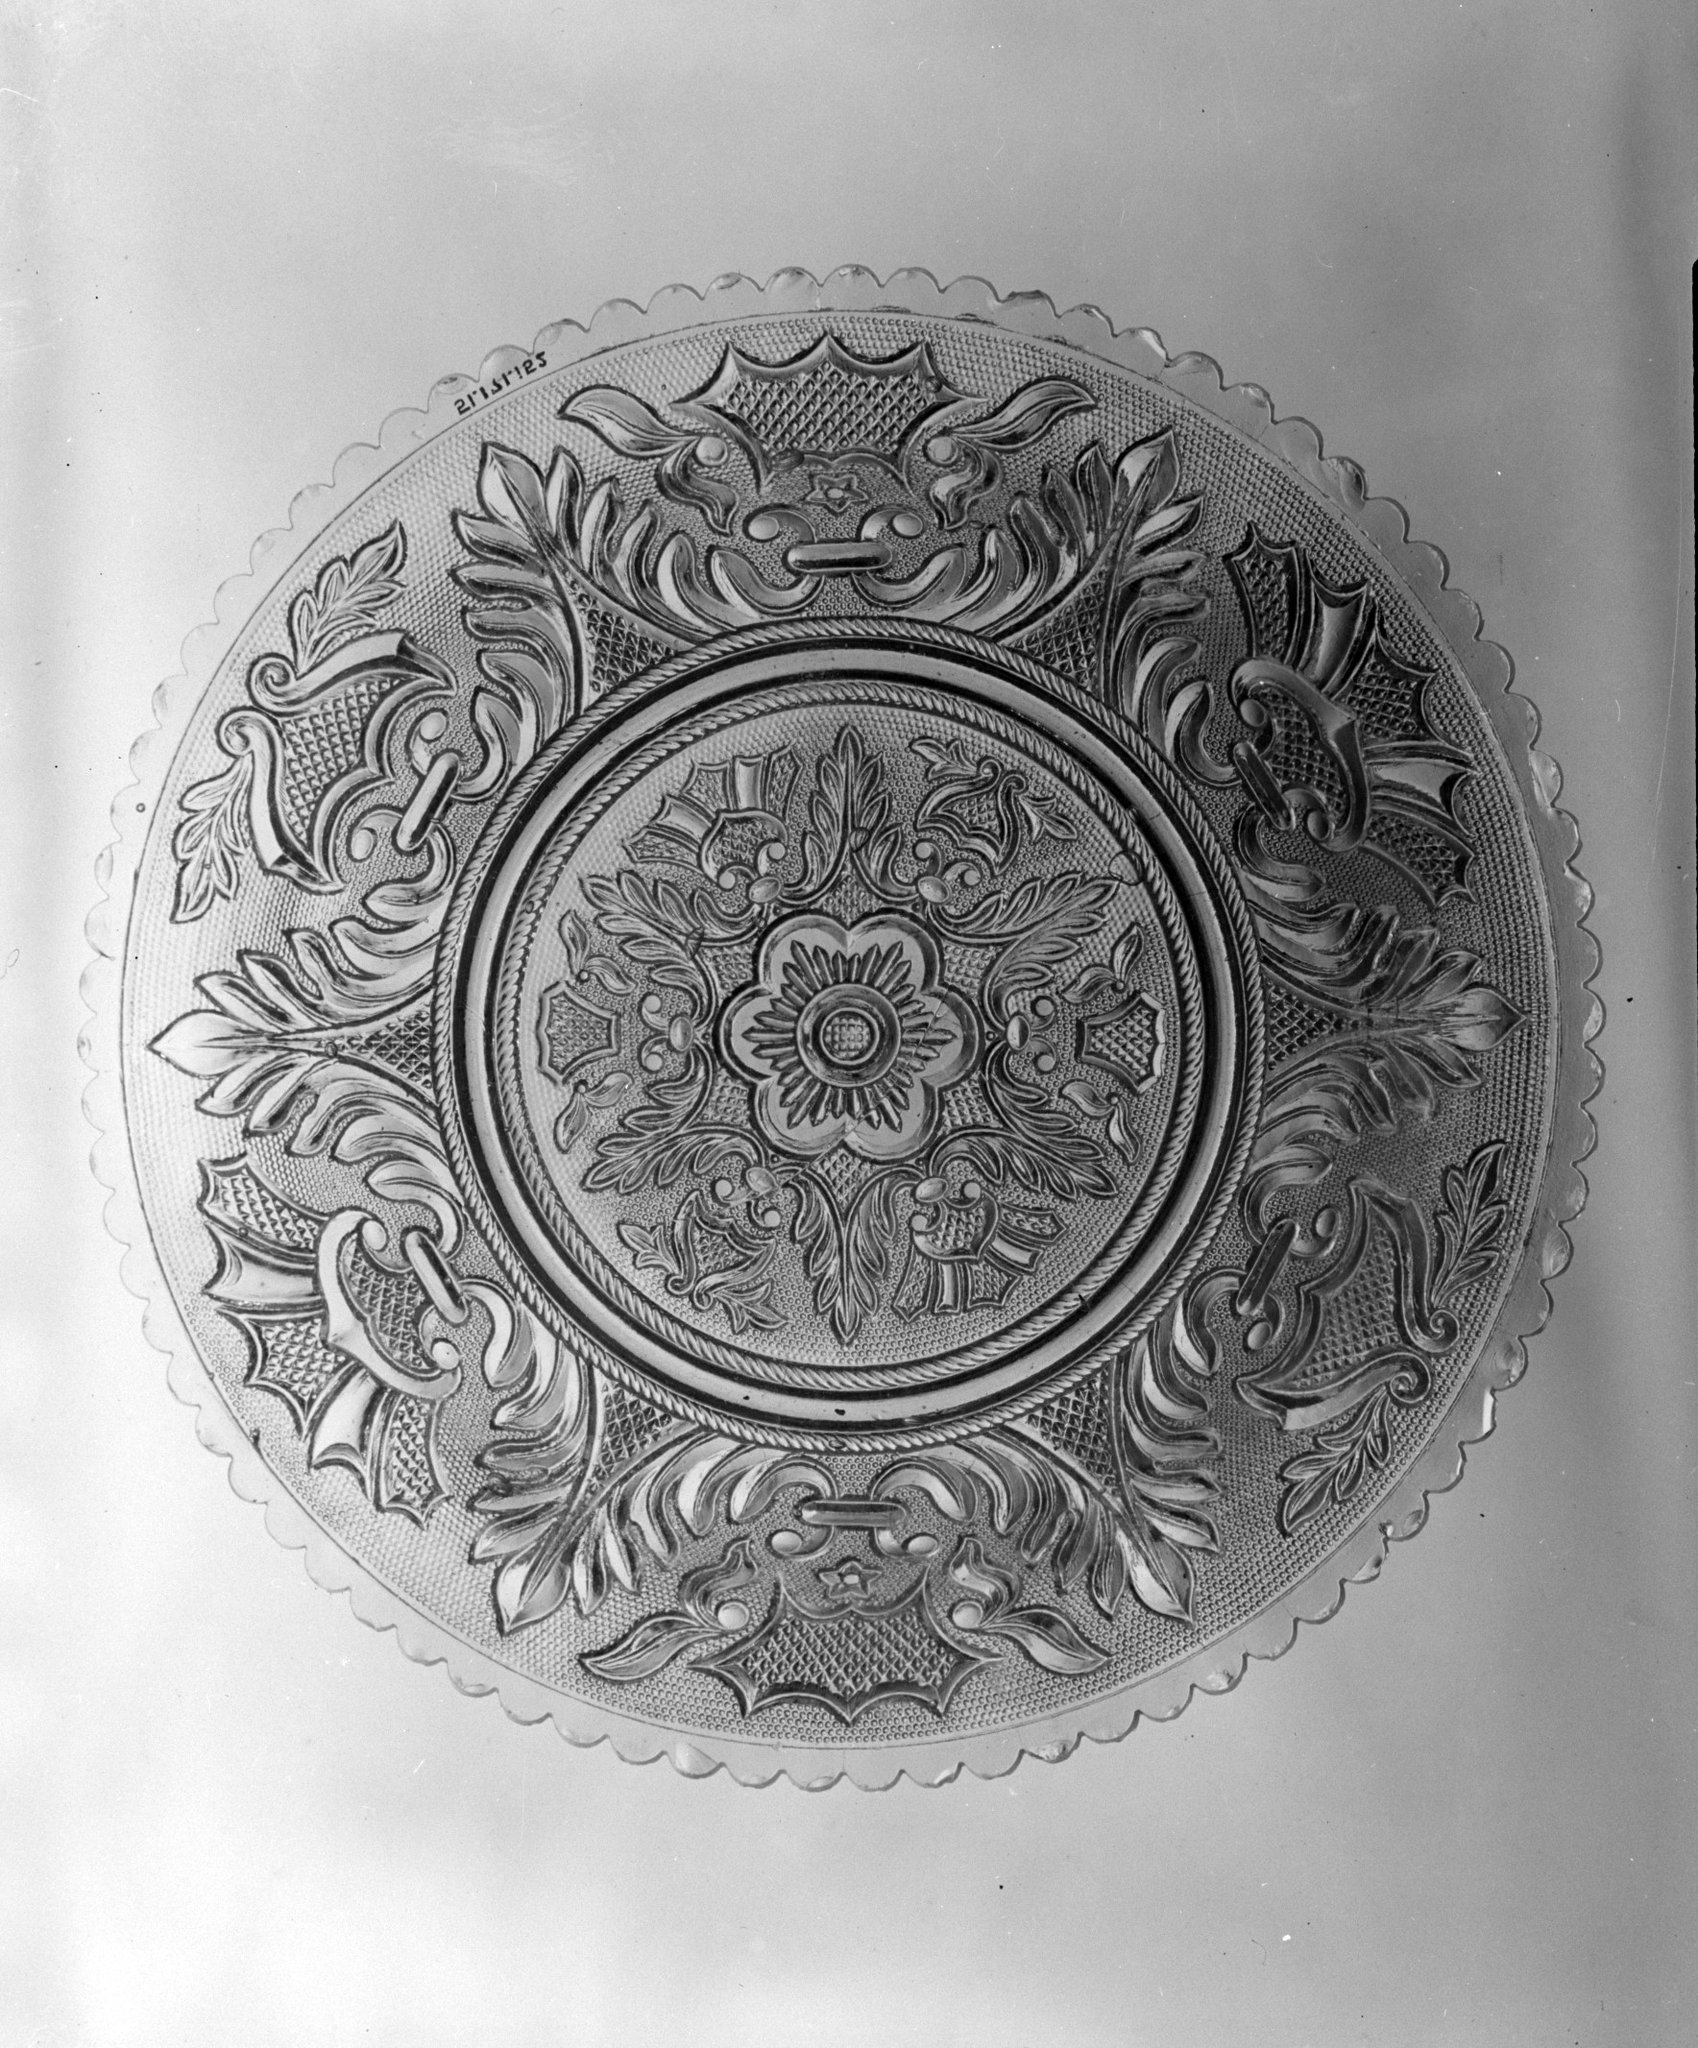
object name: bowl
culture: american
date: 1830-1840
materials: glass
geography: united states